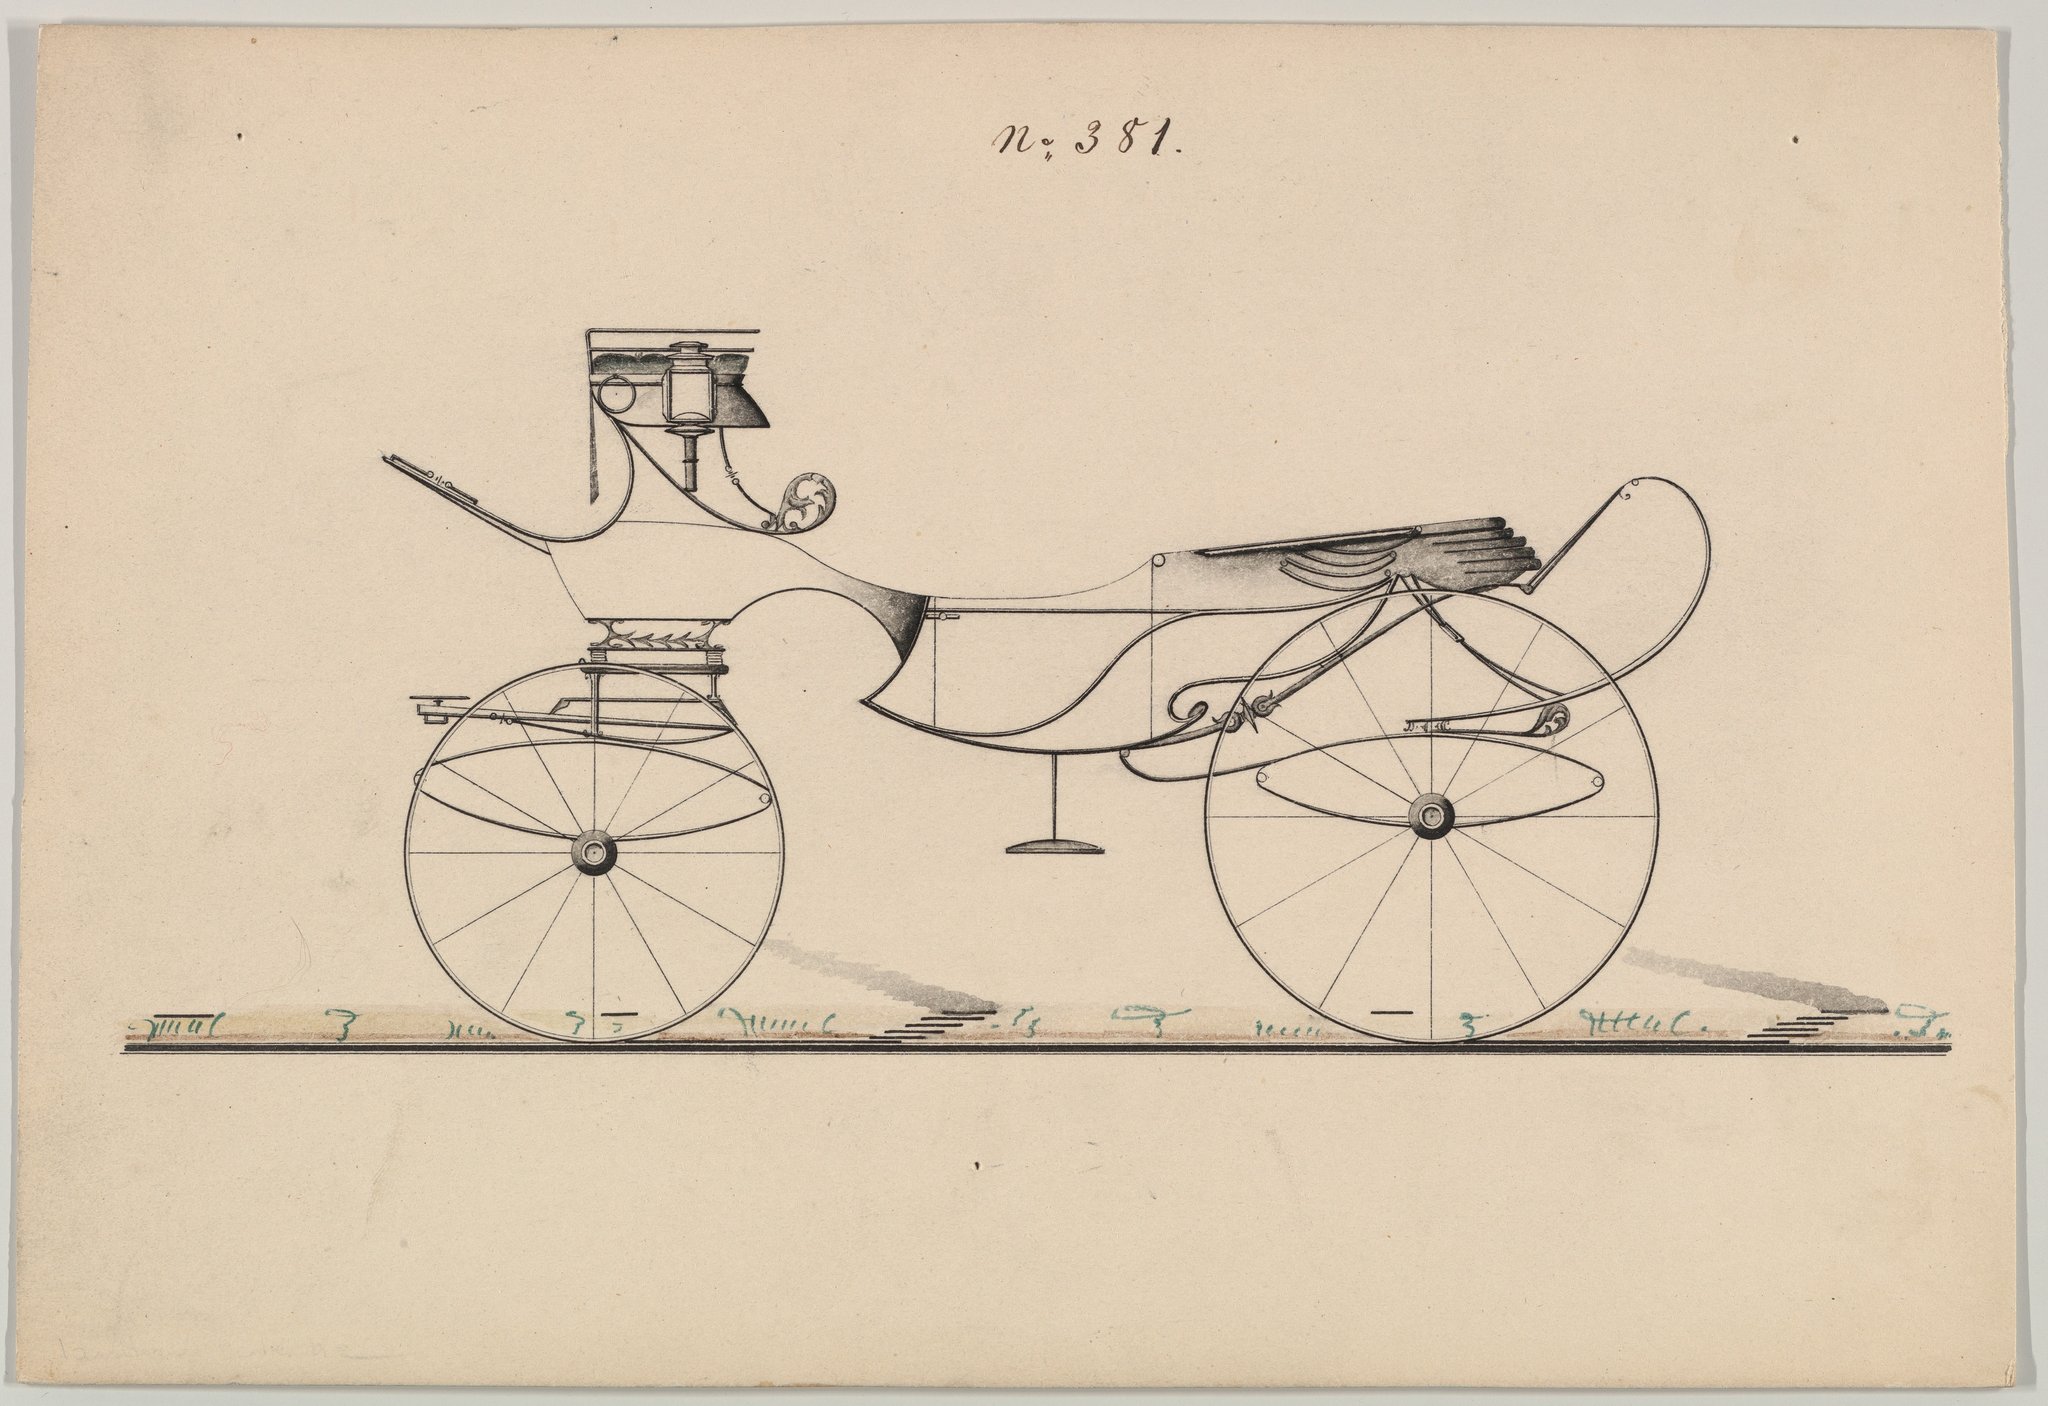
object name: drawing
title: Design for Vis-à-vis, no. 381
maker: brewster & co.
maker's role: manufacturer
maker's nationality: american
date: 1850-1870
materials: ink, watercolor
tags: carriages